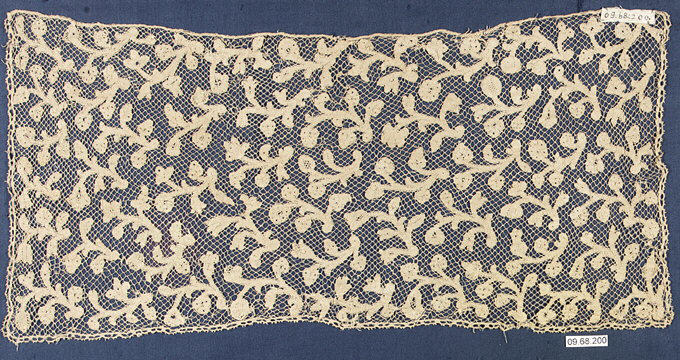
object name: cravat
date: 1701-1733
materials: lace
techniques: lace